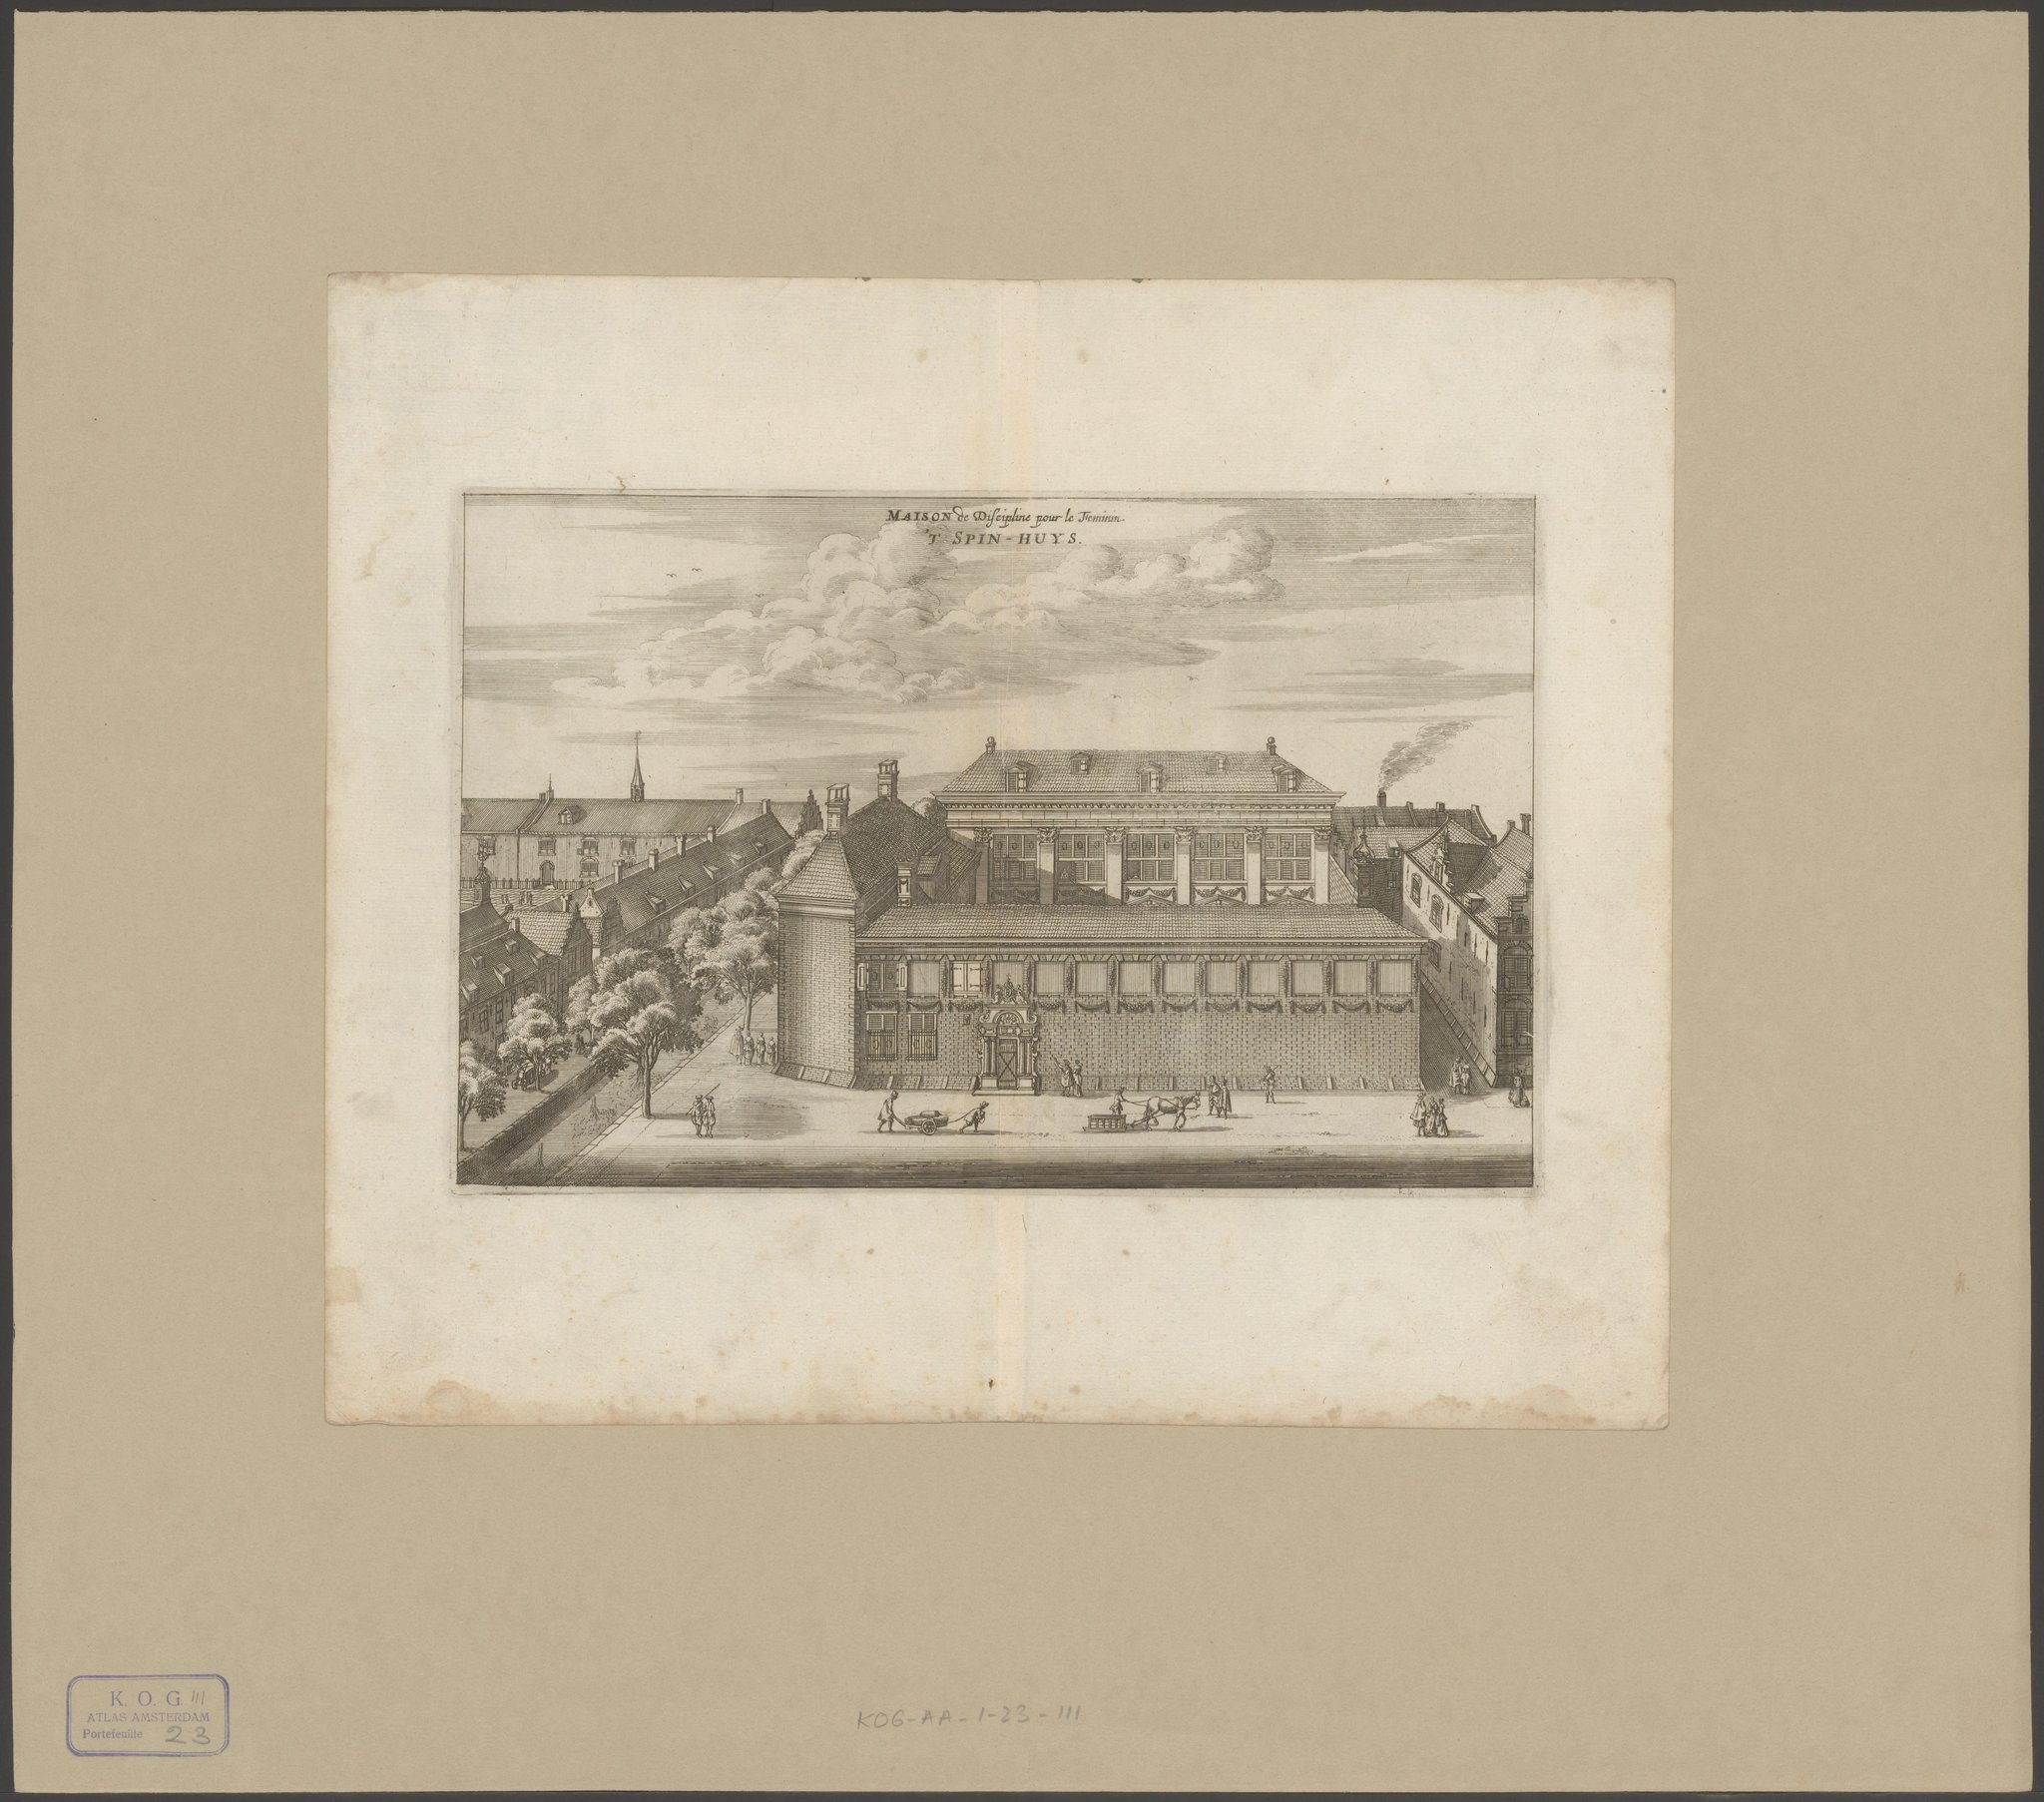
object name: book illustration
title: 't Spin-huys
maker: jacob van meurs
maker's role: draughtsman, print maker, publisher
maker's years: 1619-1680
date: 1663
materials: paper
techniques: engraving, etching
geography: amsterdam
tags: prison, jail, gate, entrance, workhouse, penal camp, penitentiary, chain gang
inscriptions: collector's mark: Lugt 1641b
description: Prent mogelijk uit: Dapper, Olfert. Historische beschryving der stadt Amsterdam (…). Amsterdam: Jacob van Meurs, 1663. Bij sommige exemplaren van deze uitgave werd een eerdere staat ingebonden waarop boven de Nederlandse titel geen Franse staat.